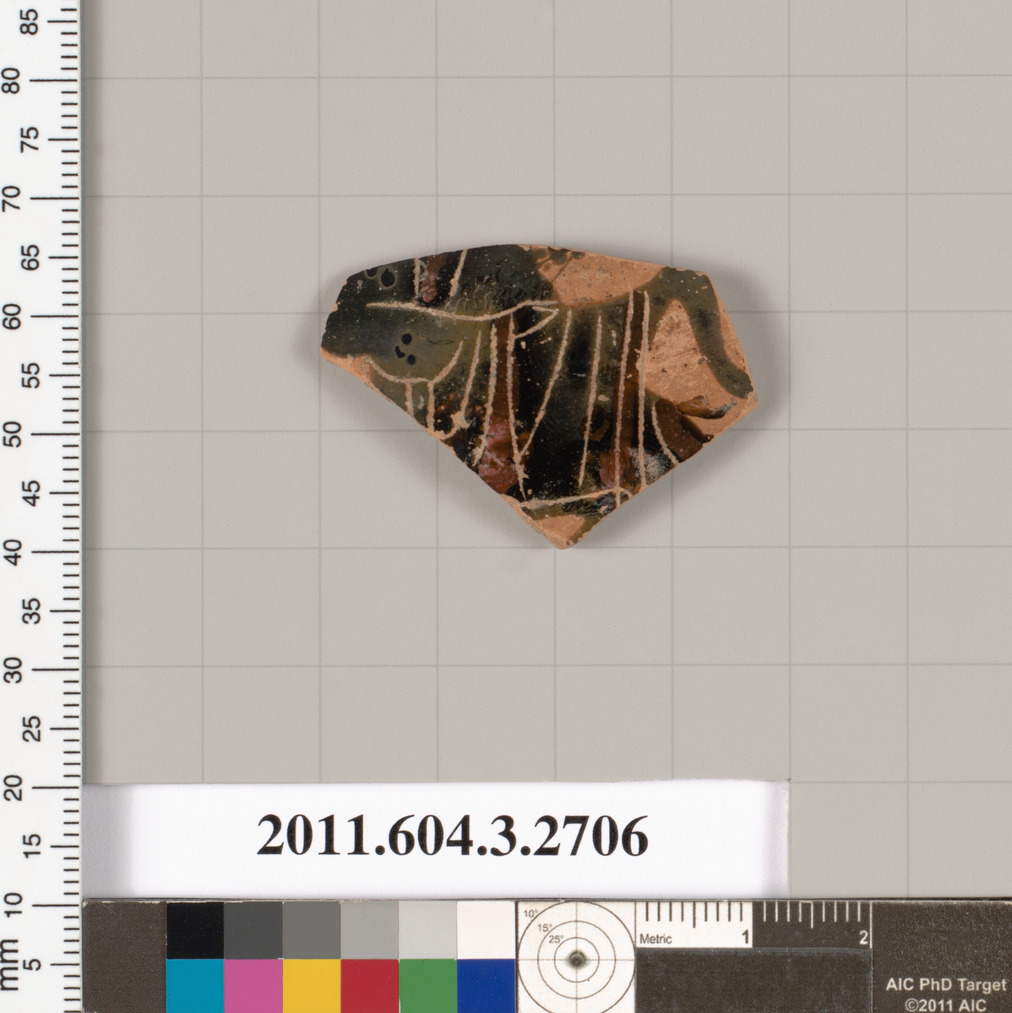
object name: oinochoe fragment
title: Terracotta fragment of an oinochoe (jug)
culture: greek, attic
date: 534-468 BCE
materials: terracotta